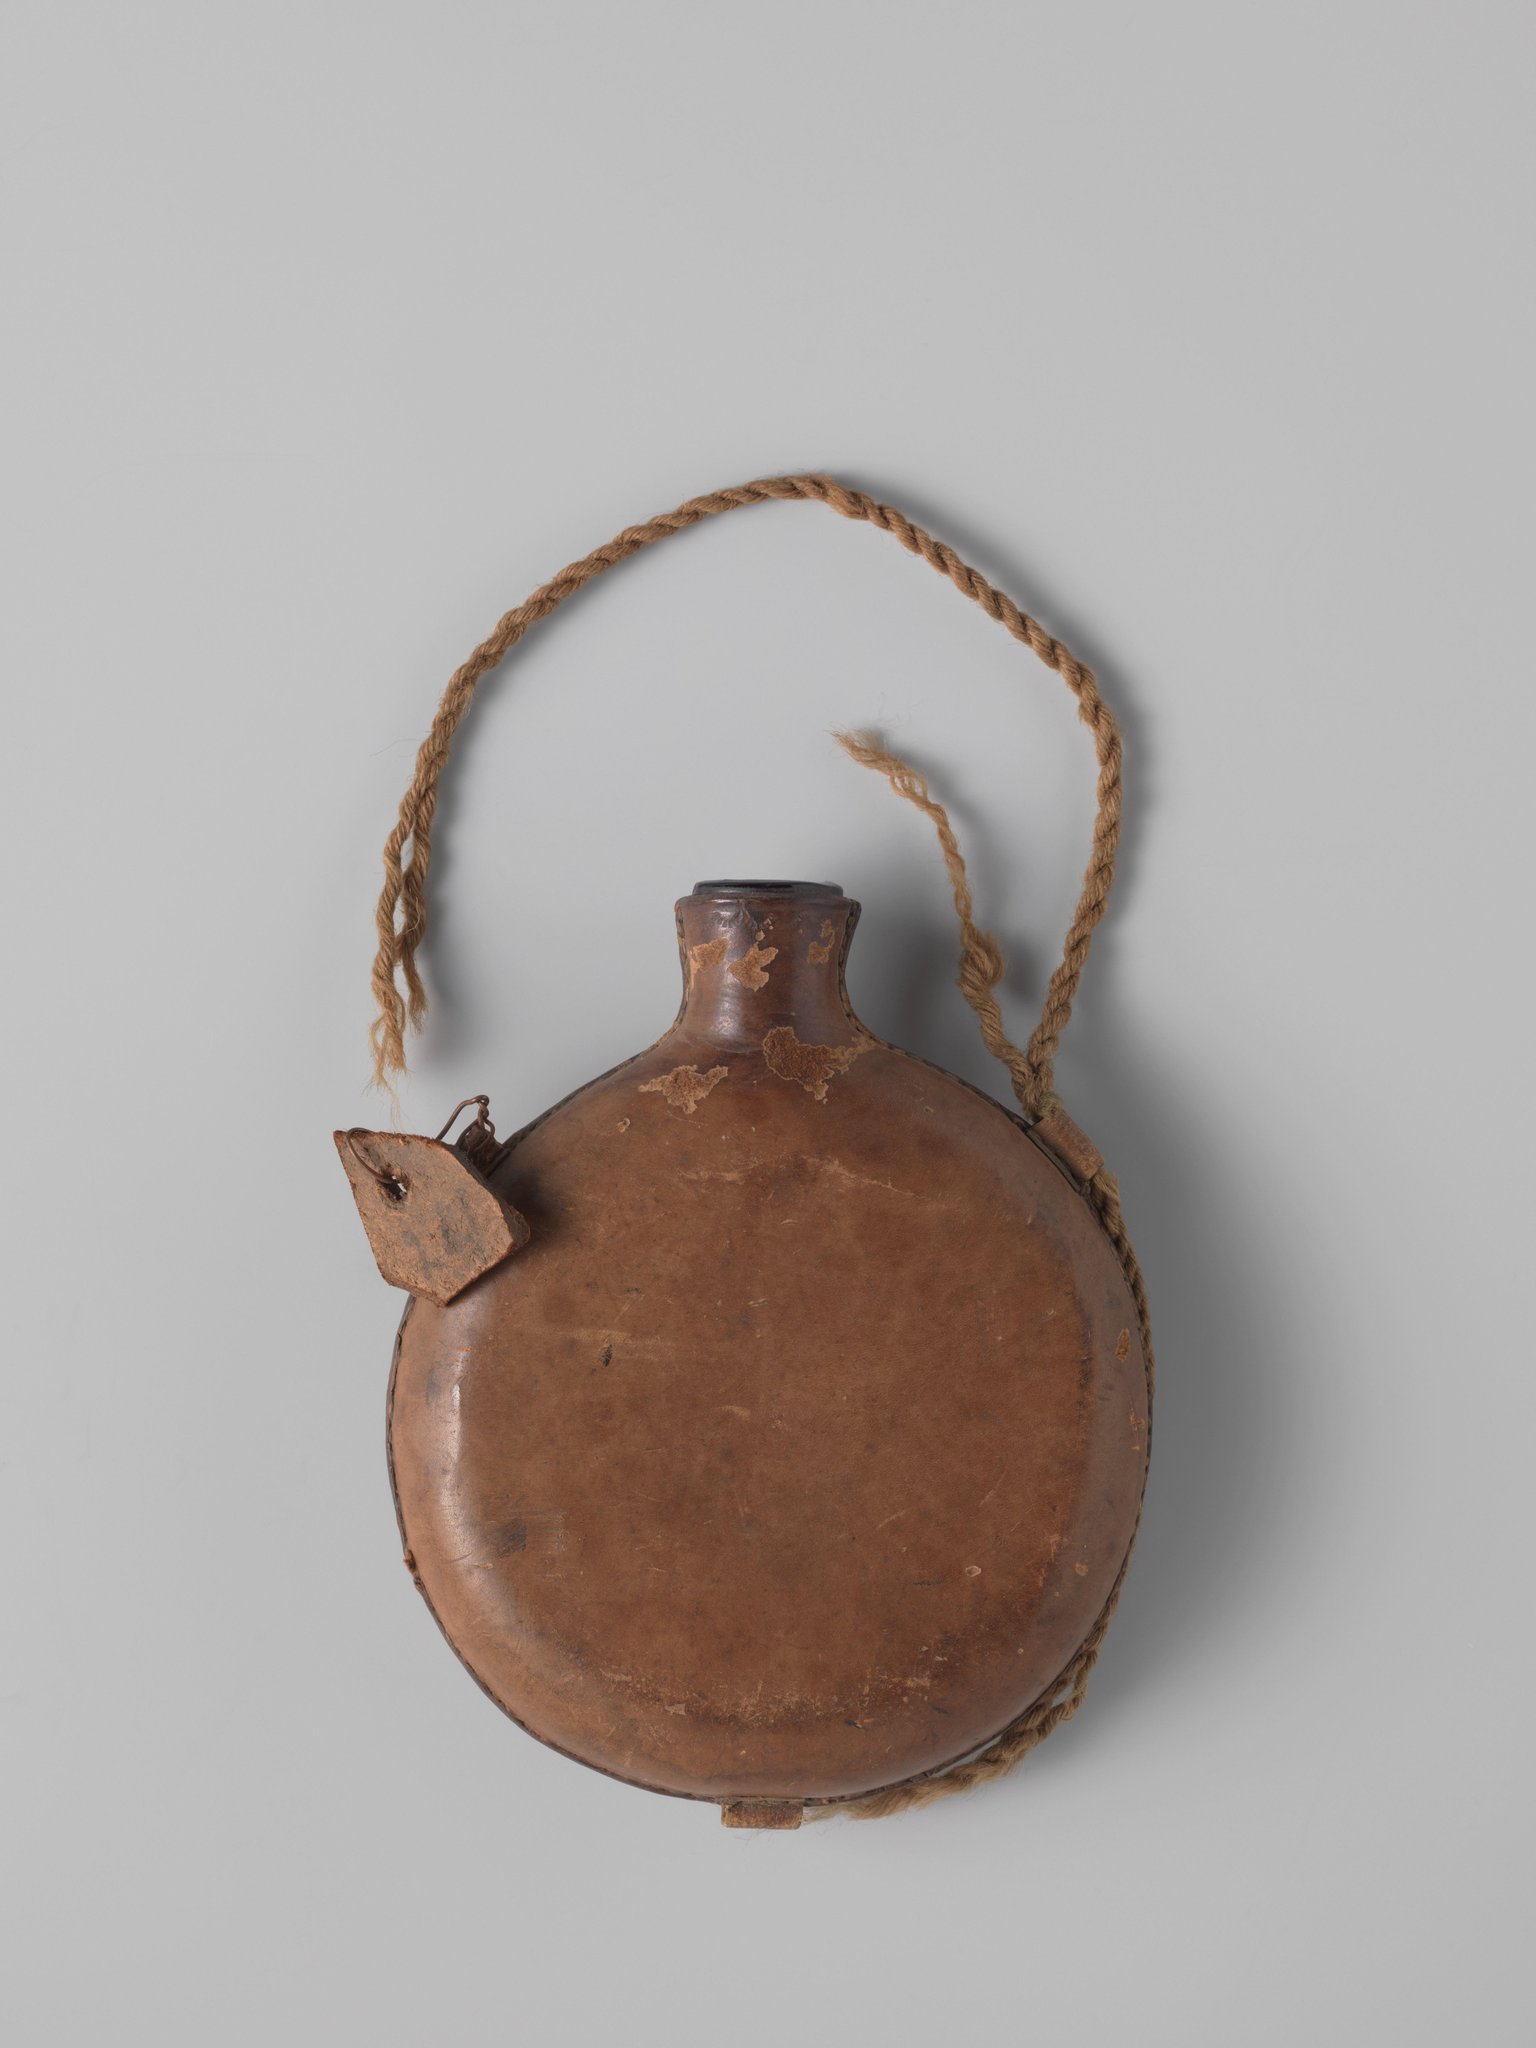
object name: canteen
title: Veldfles gebruikt door J.W. Kalkhoven, in 1830/32 Luitenant Kolonel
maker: Anonymous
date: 1800-1830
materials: leather, fiber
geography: netherlands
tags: netherlands, belgium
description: Veldfles van eenvoudig bruin leer. Ooit nog in éen stuk, nu in brokstukken.